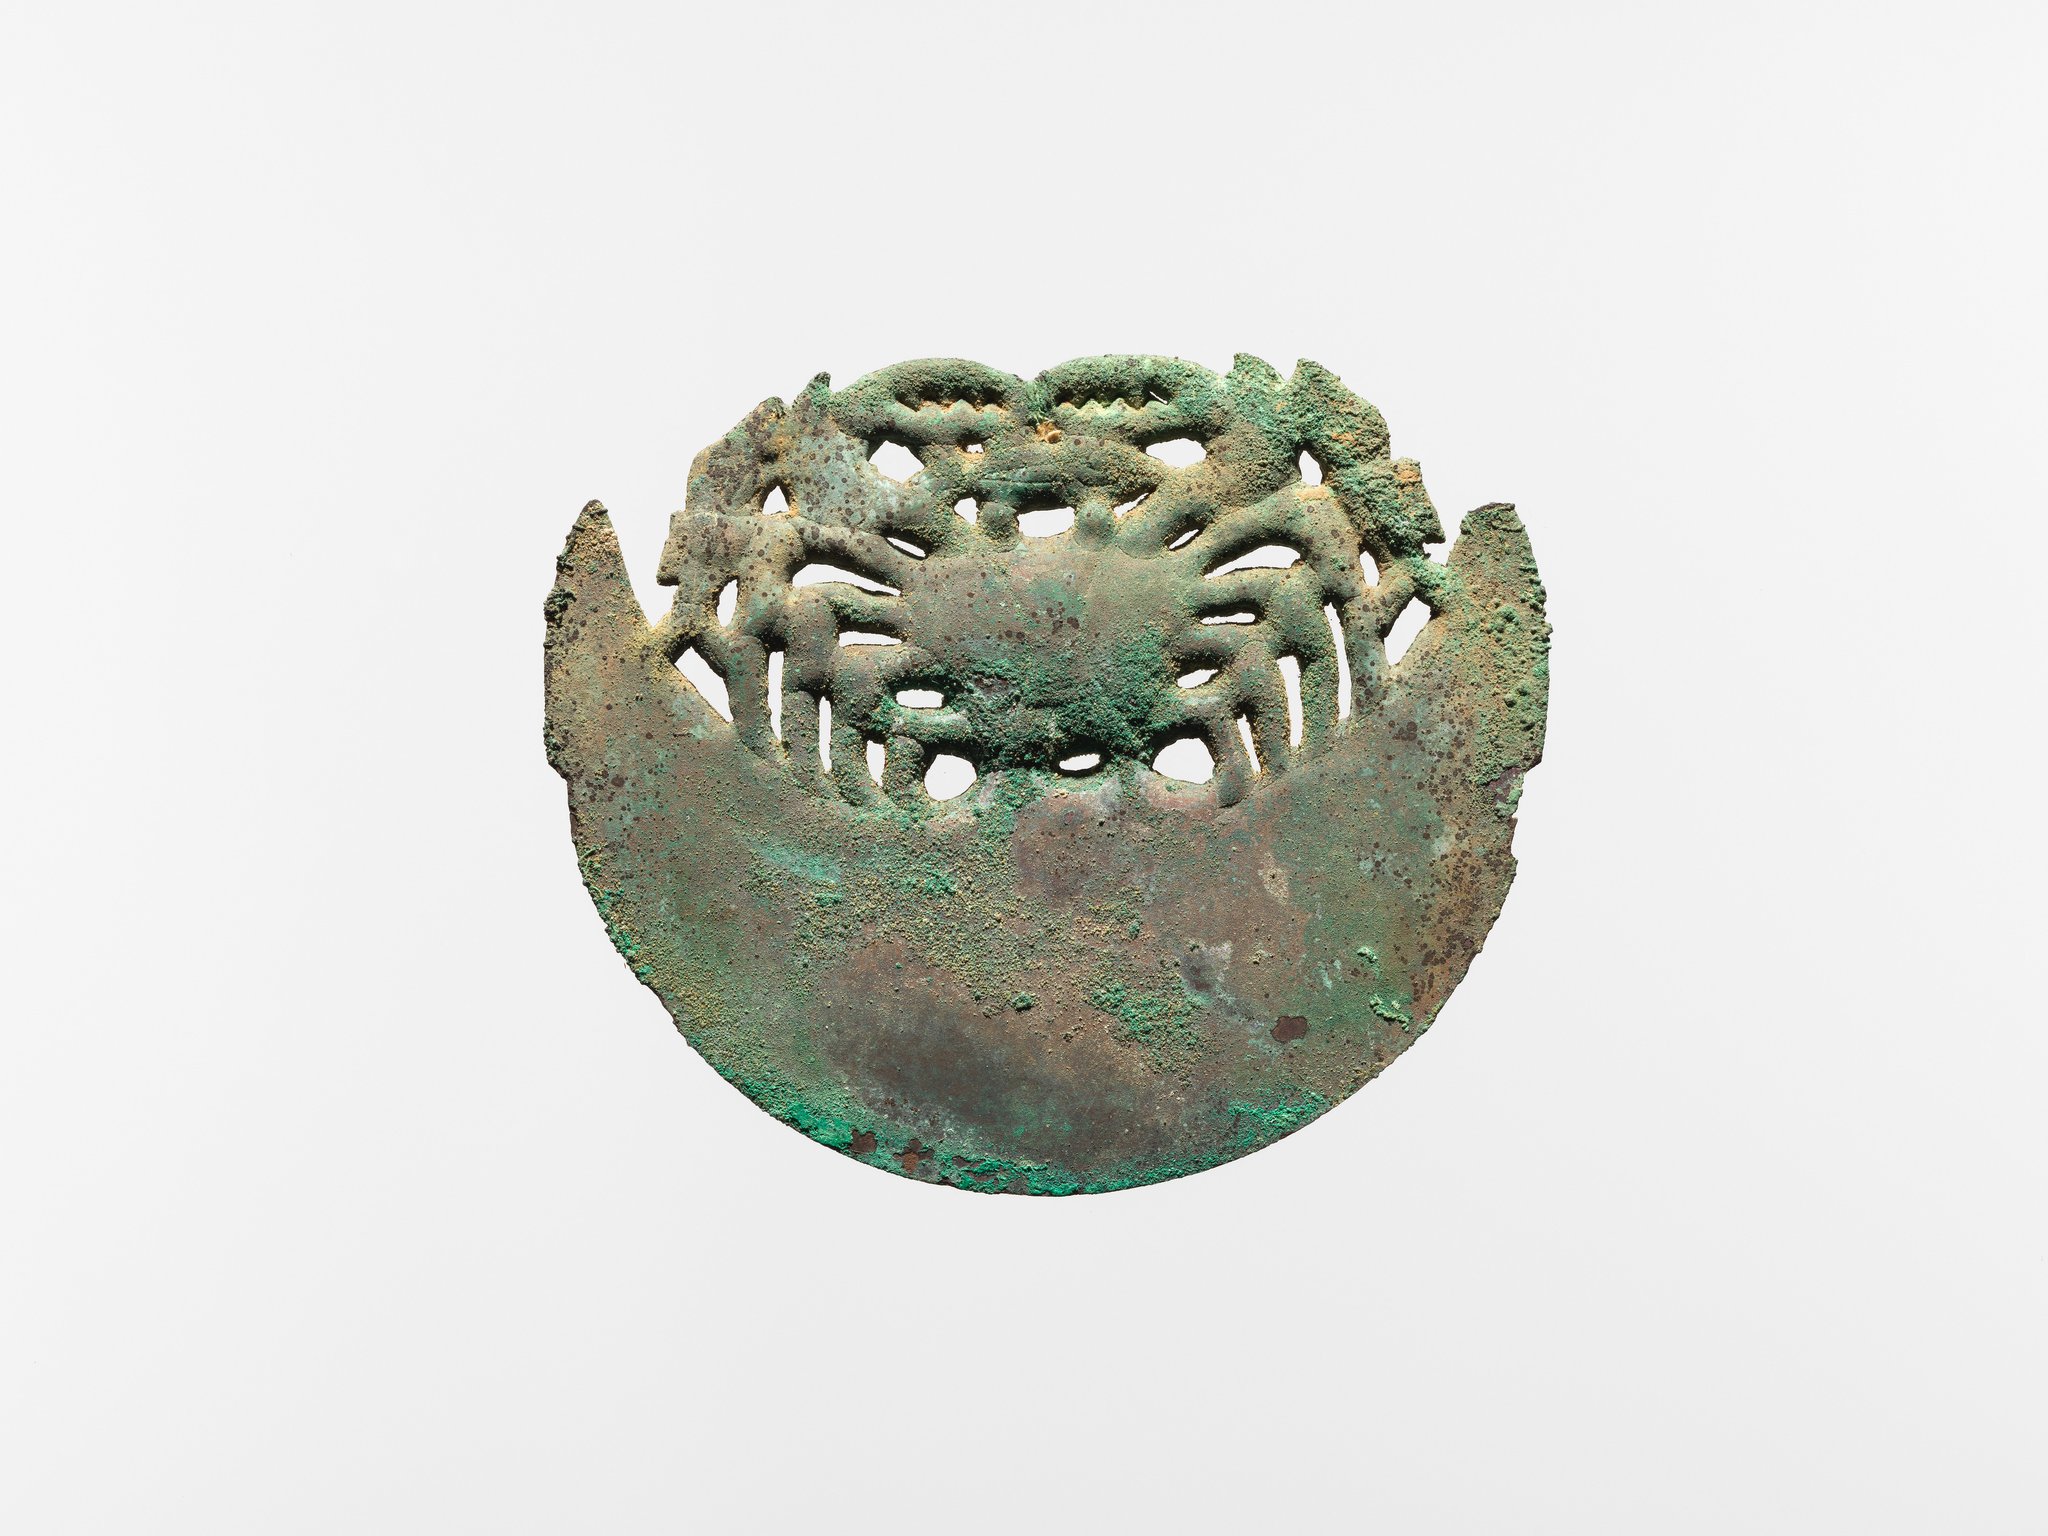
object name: ornament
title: Crescent Ornament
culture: moche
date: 501-700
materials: copper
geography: peru